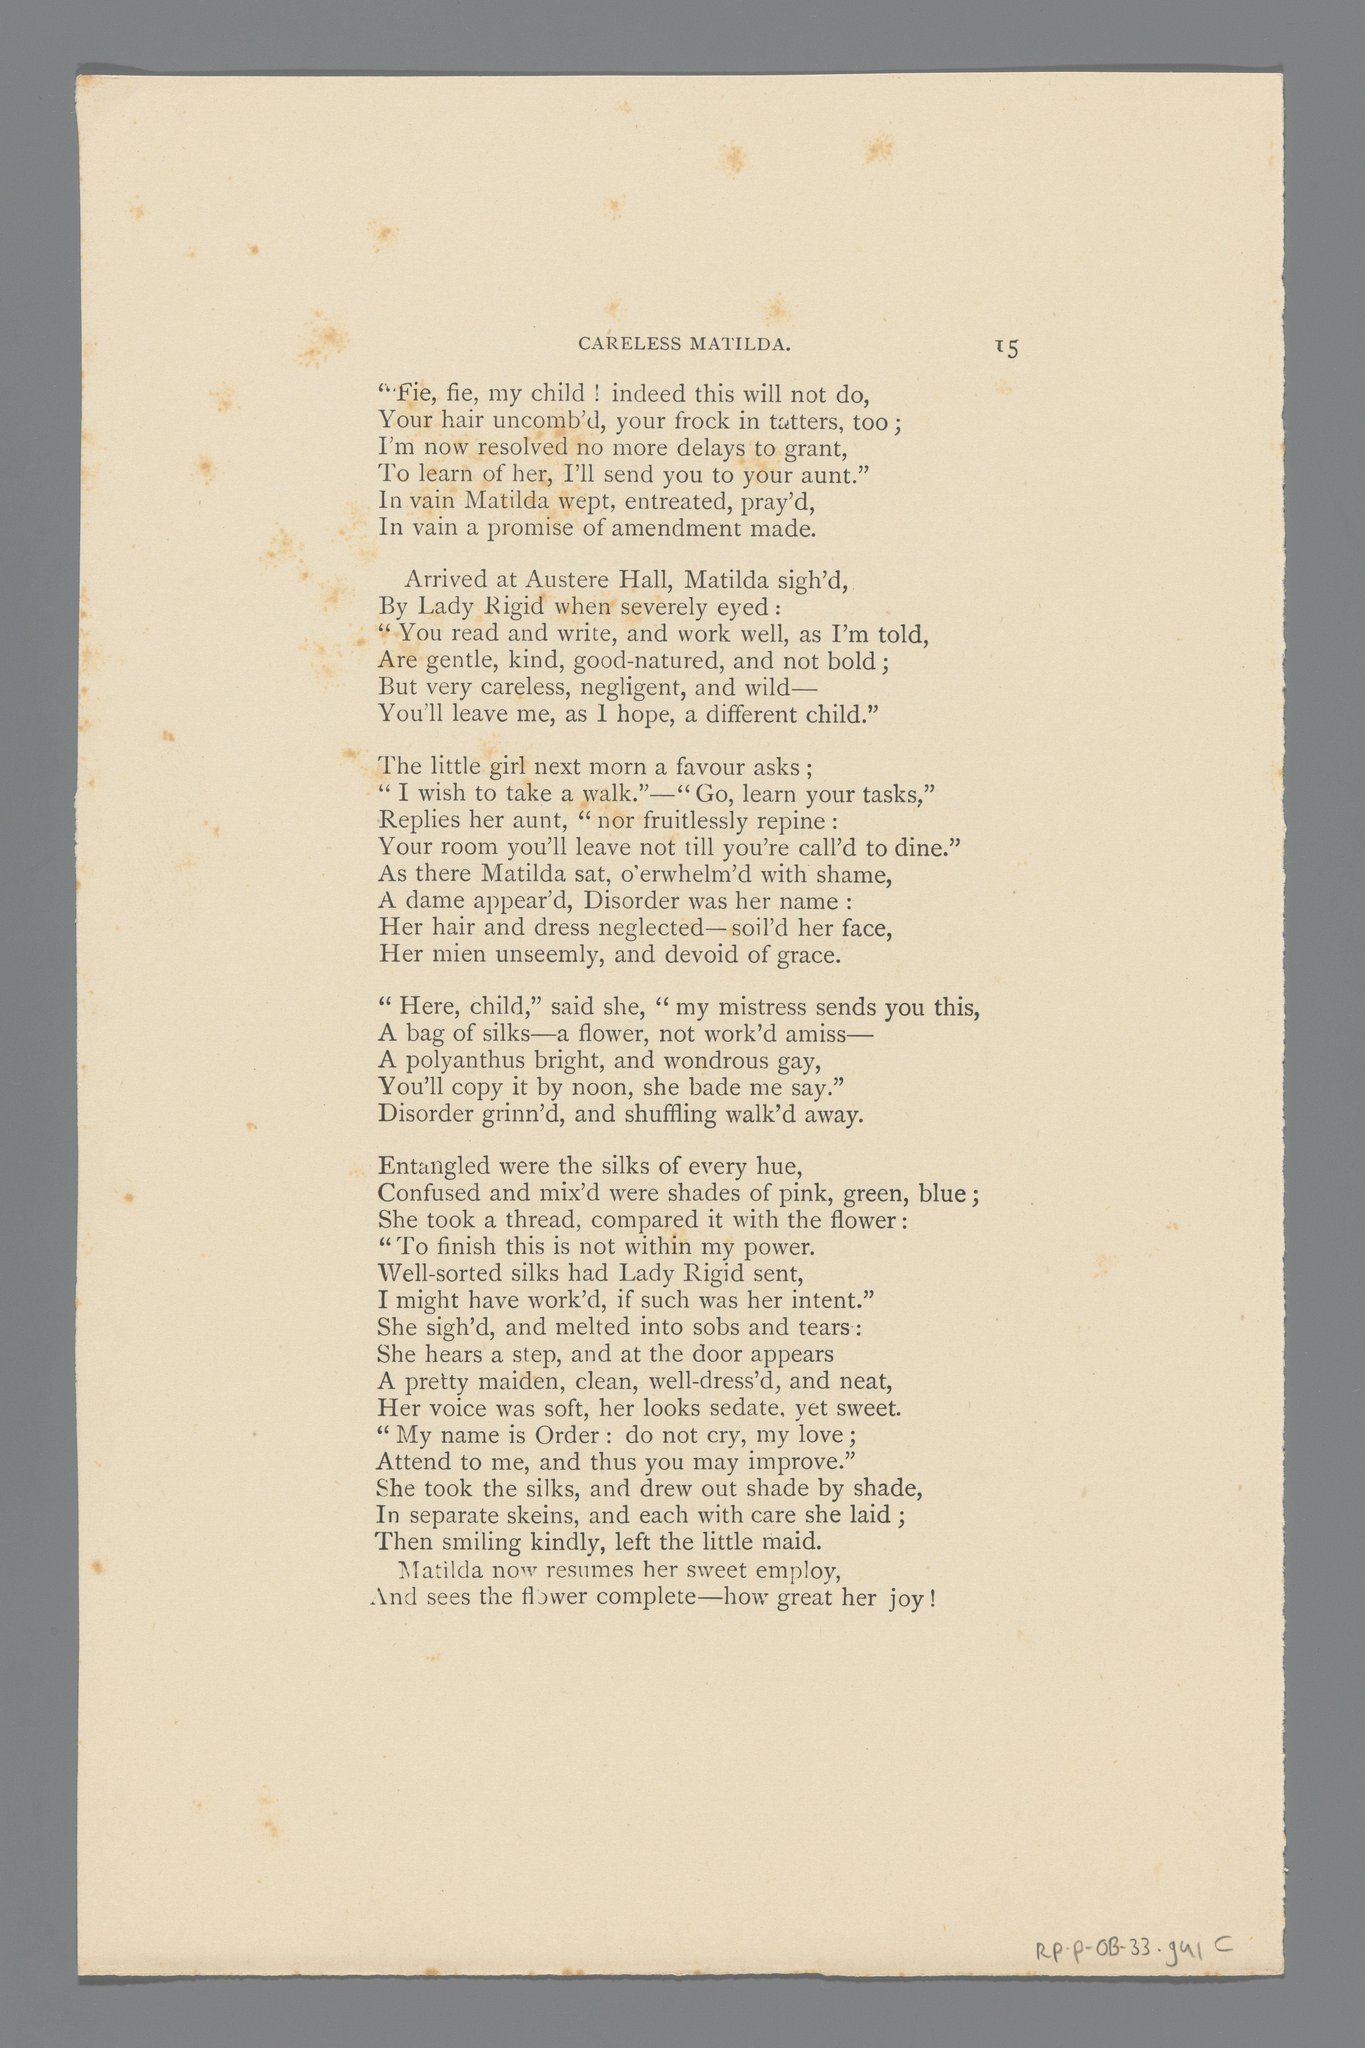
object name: text sheet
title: Tekstblad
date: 1883-1927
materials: paper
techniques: letterpress printing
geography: london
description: Tekstblad uit: Jane en Ann Taylor. Little Ann and other poems. Londen: George Routledge & Sons, [1883], p. 15-16. Of een latere uitgave.